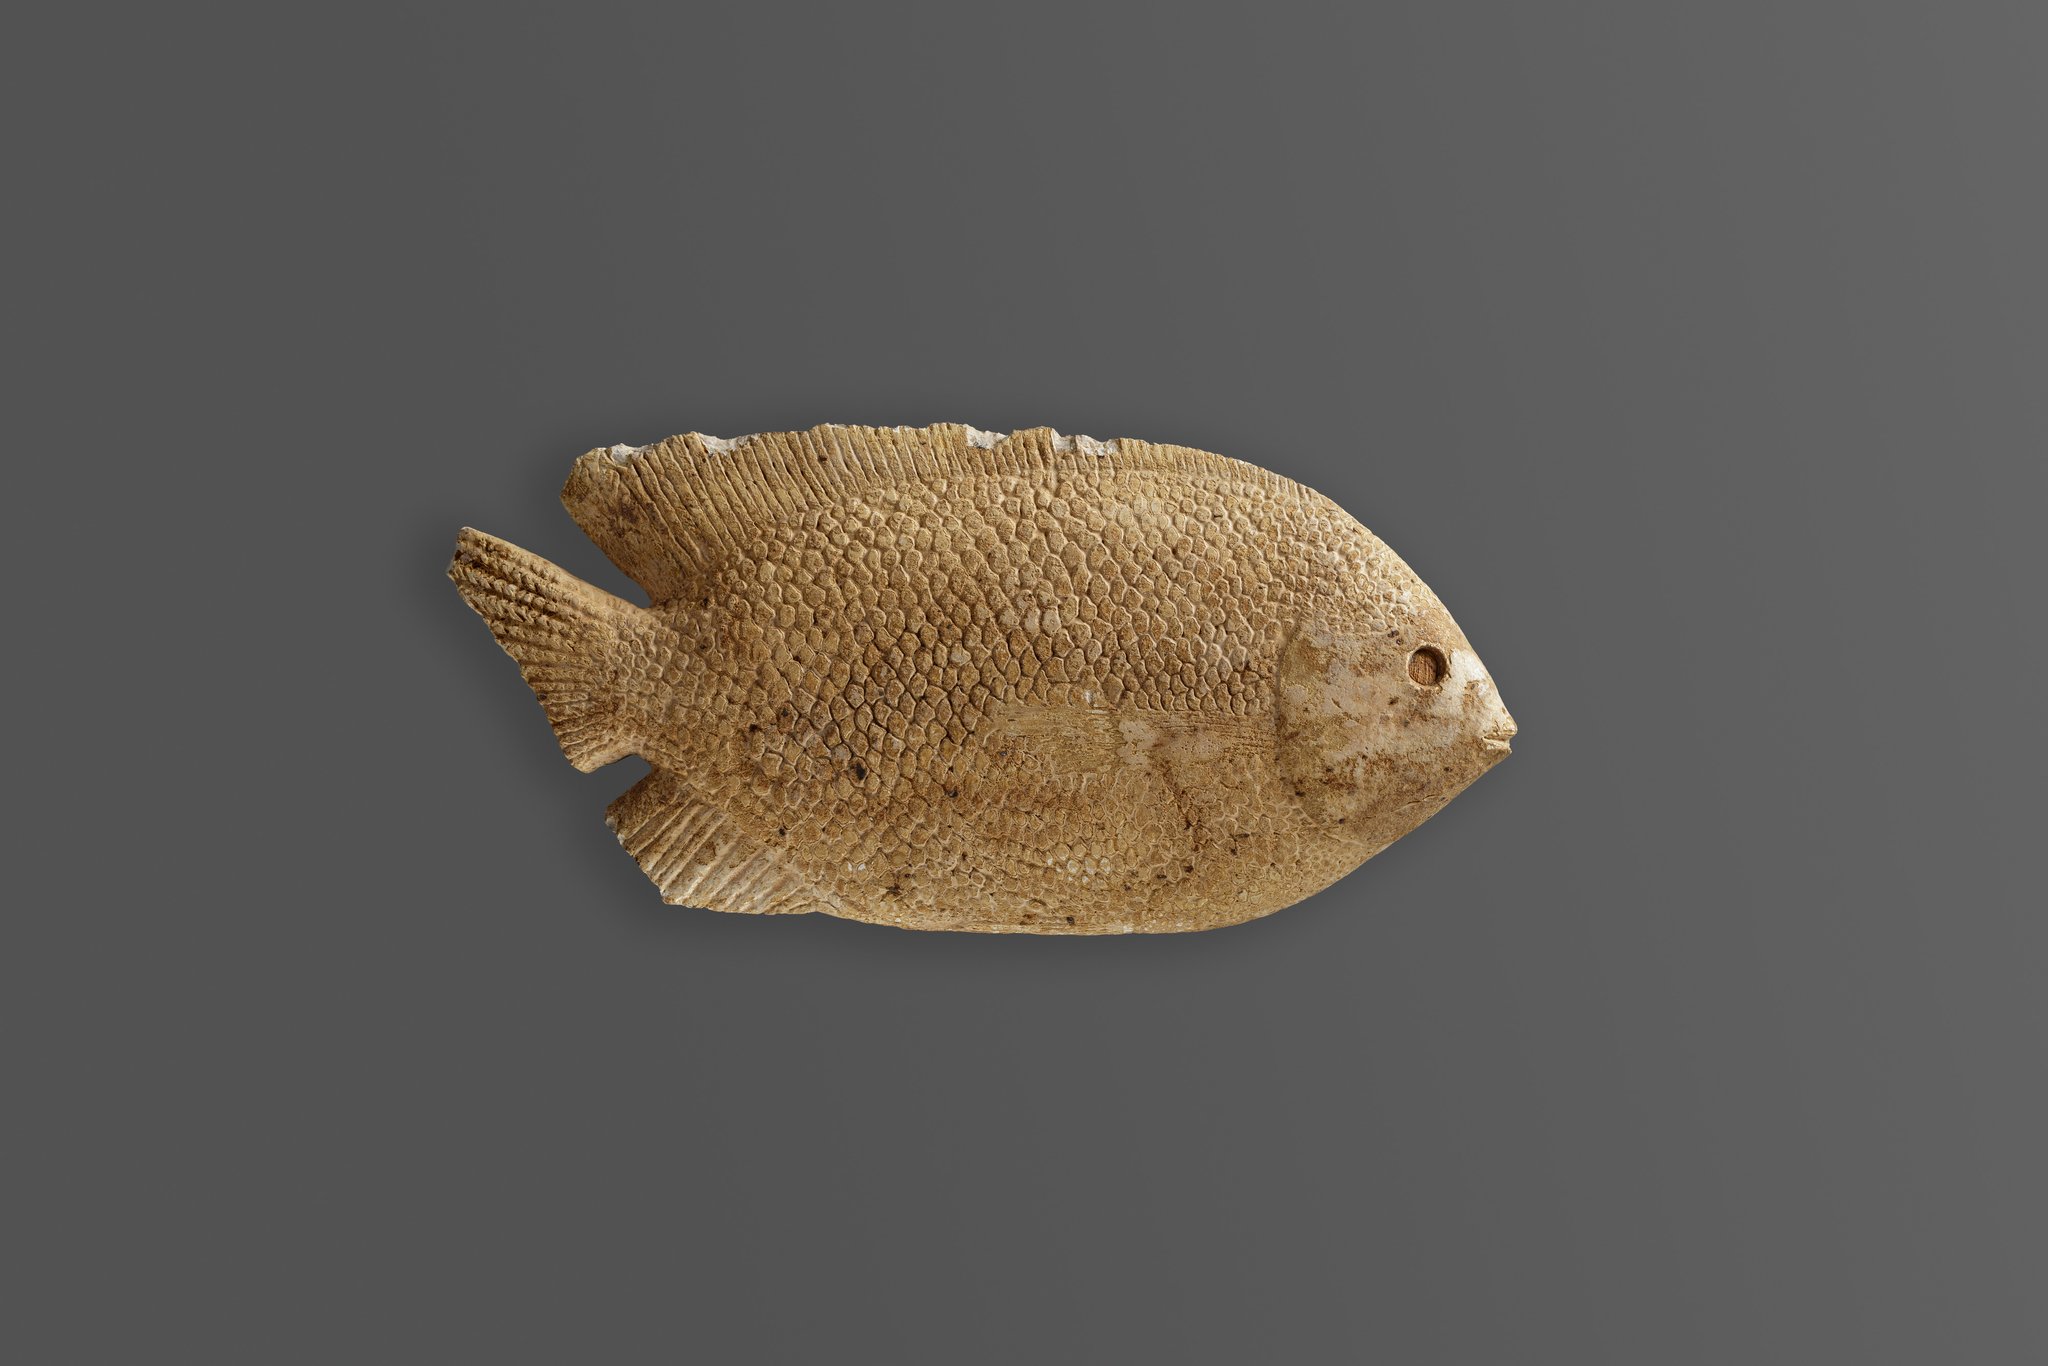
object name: dish, fish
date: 1295-1070 BCE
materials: stone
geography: egypt